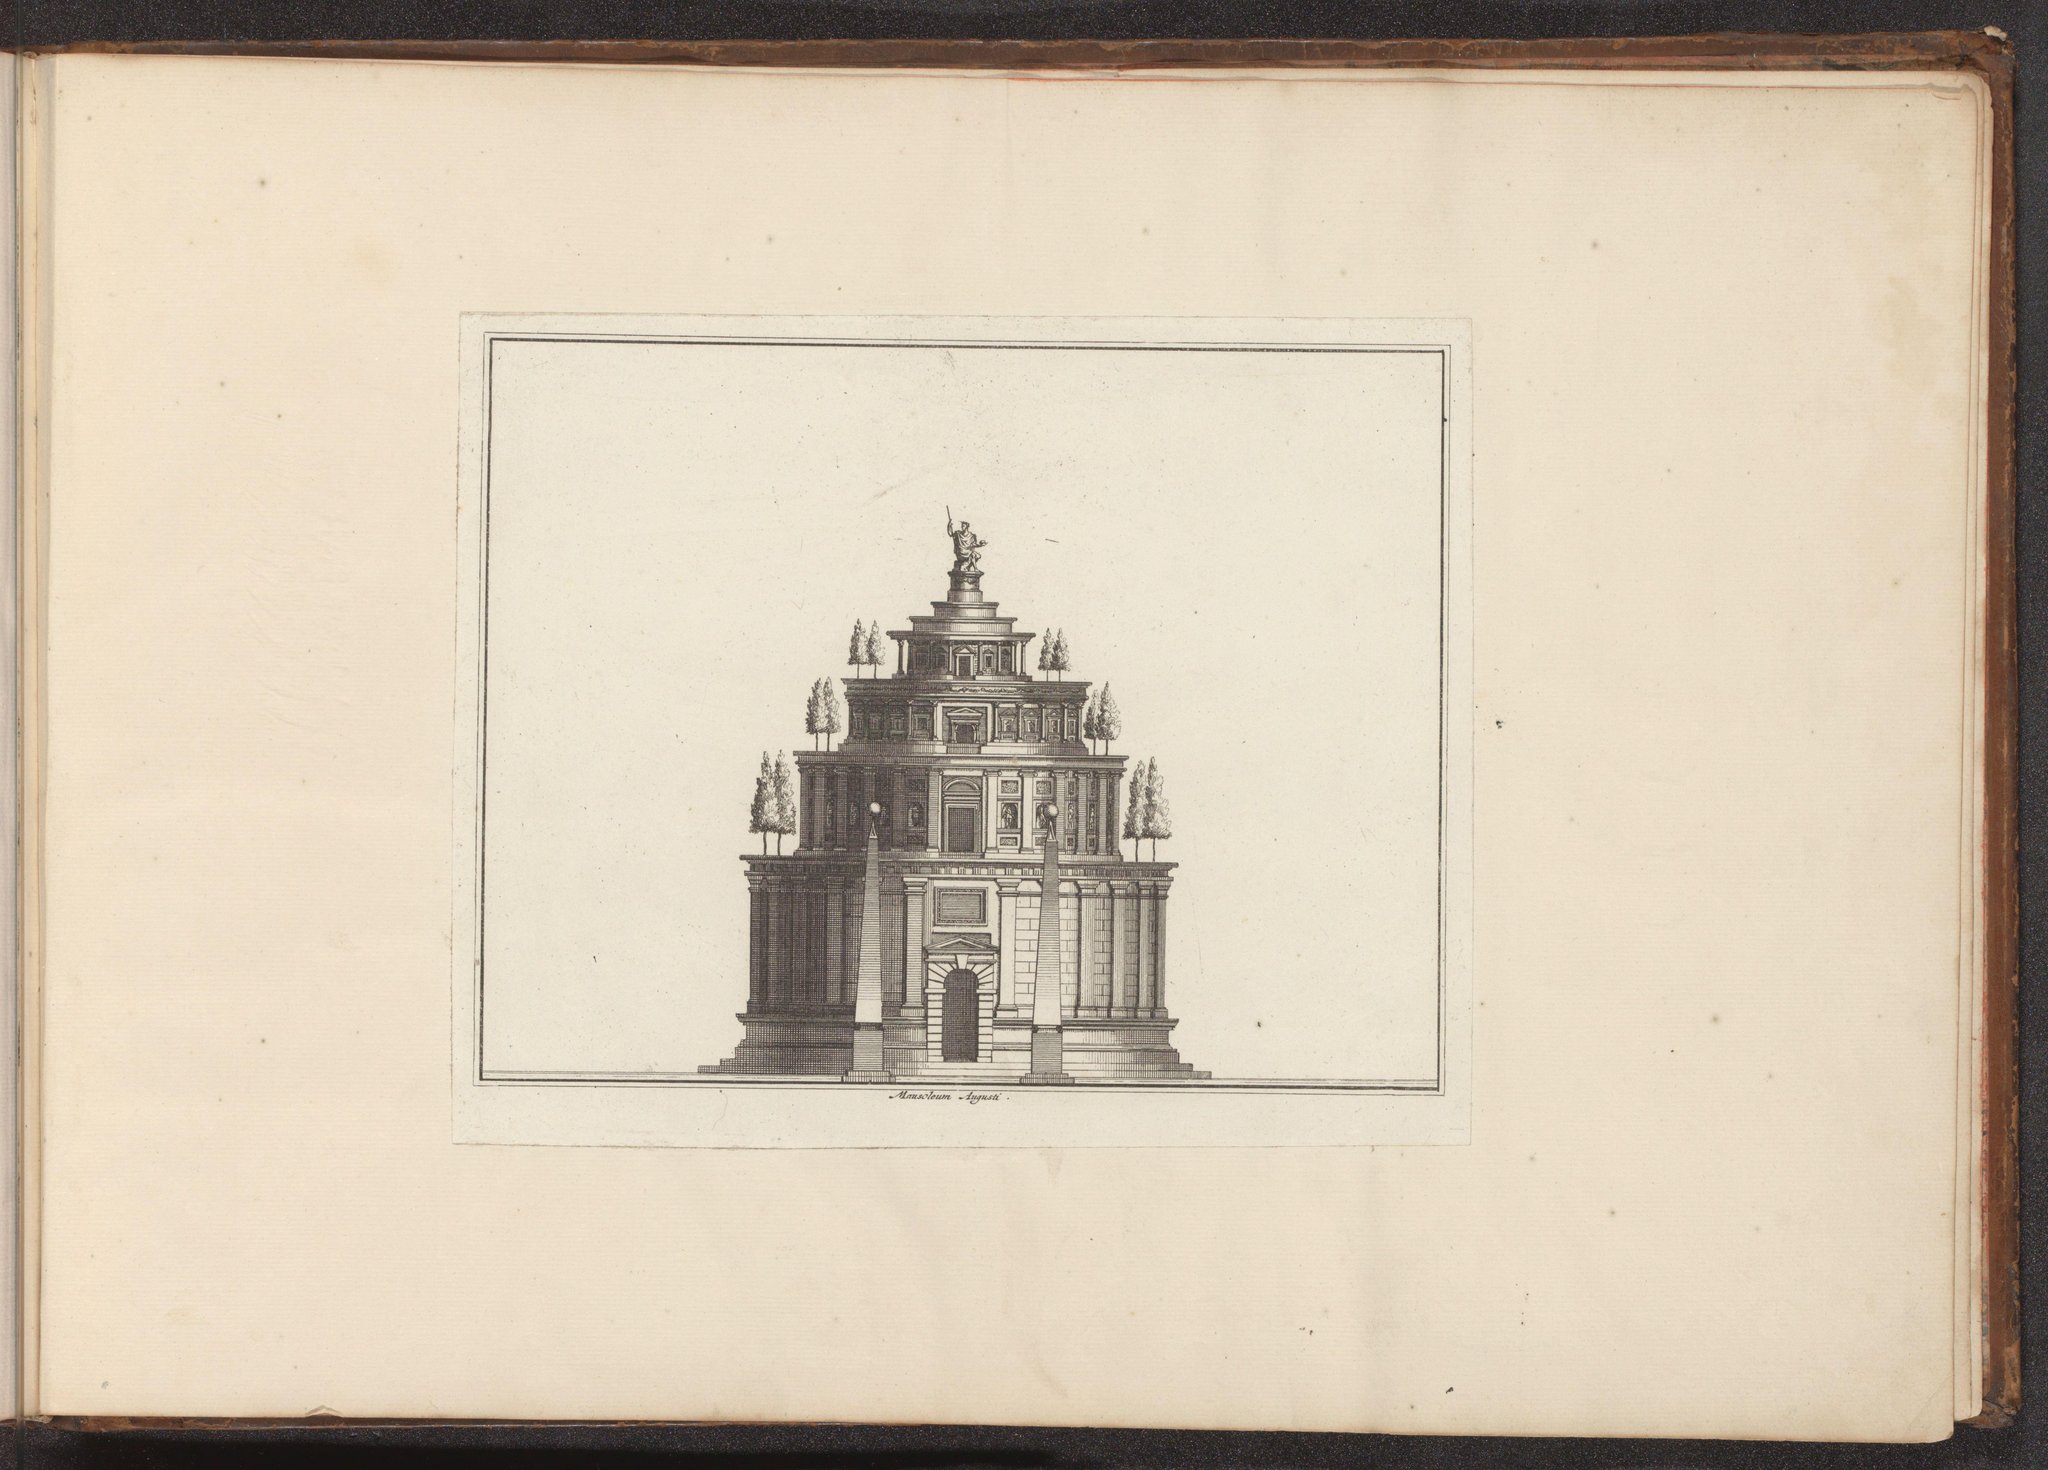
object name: print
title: Mausoleum Augusti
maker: Anonymous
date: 1700-1710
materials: paper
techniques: etching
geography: france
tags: mausoleum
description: Een reconstructie van het Mausoleum van Augustus te Rome. De prent maakt deel uit van een album.